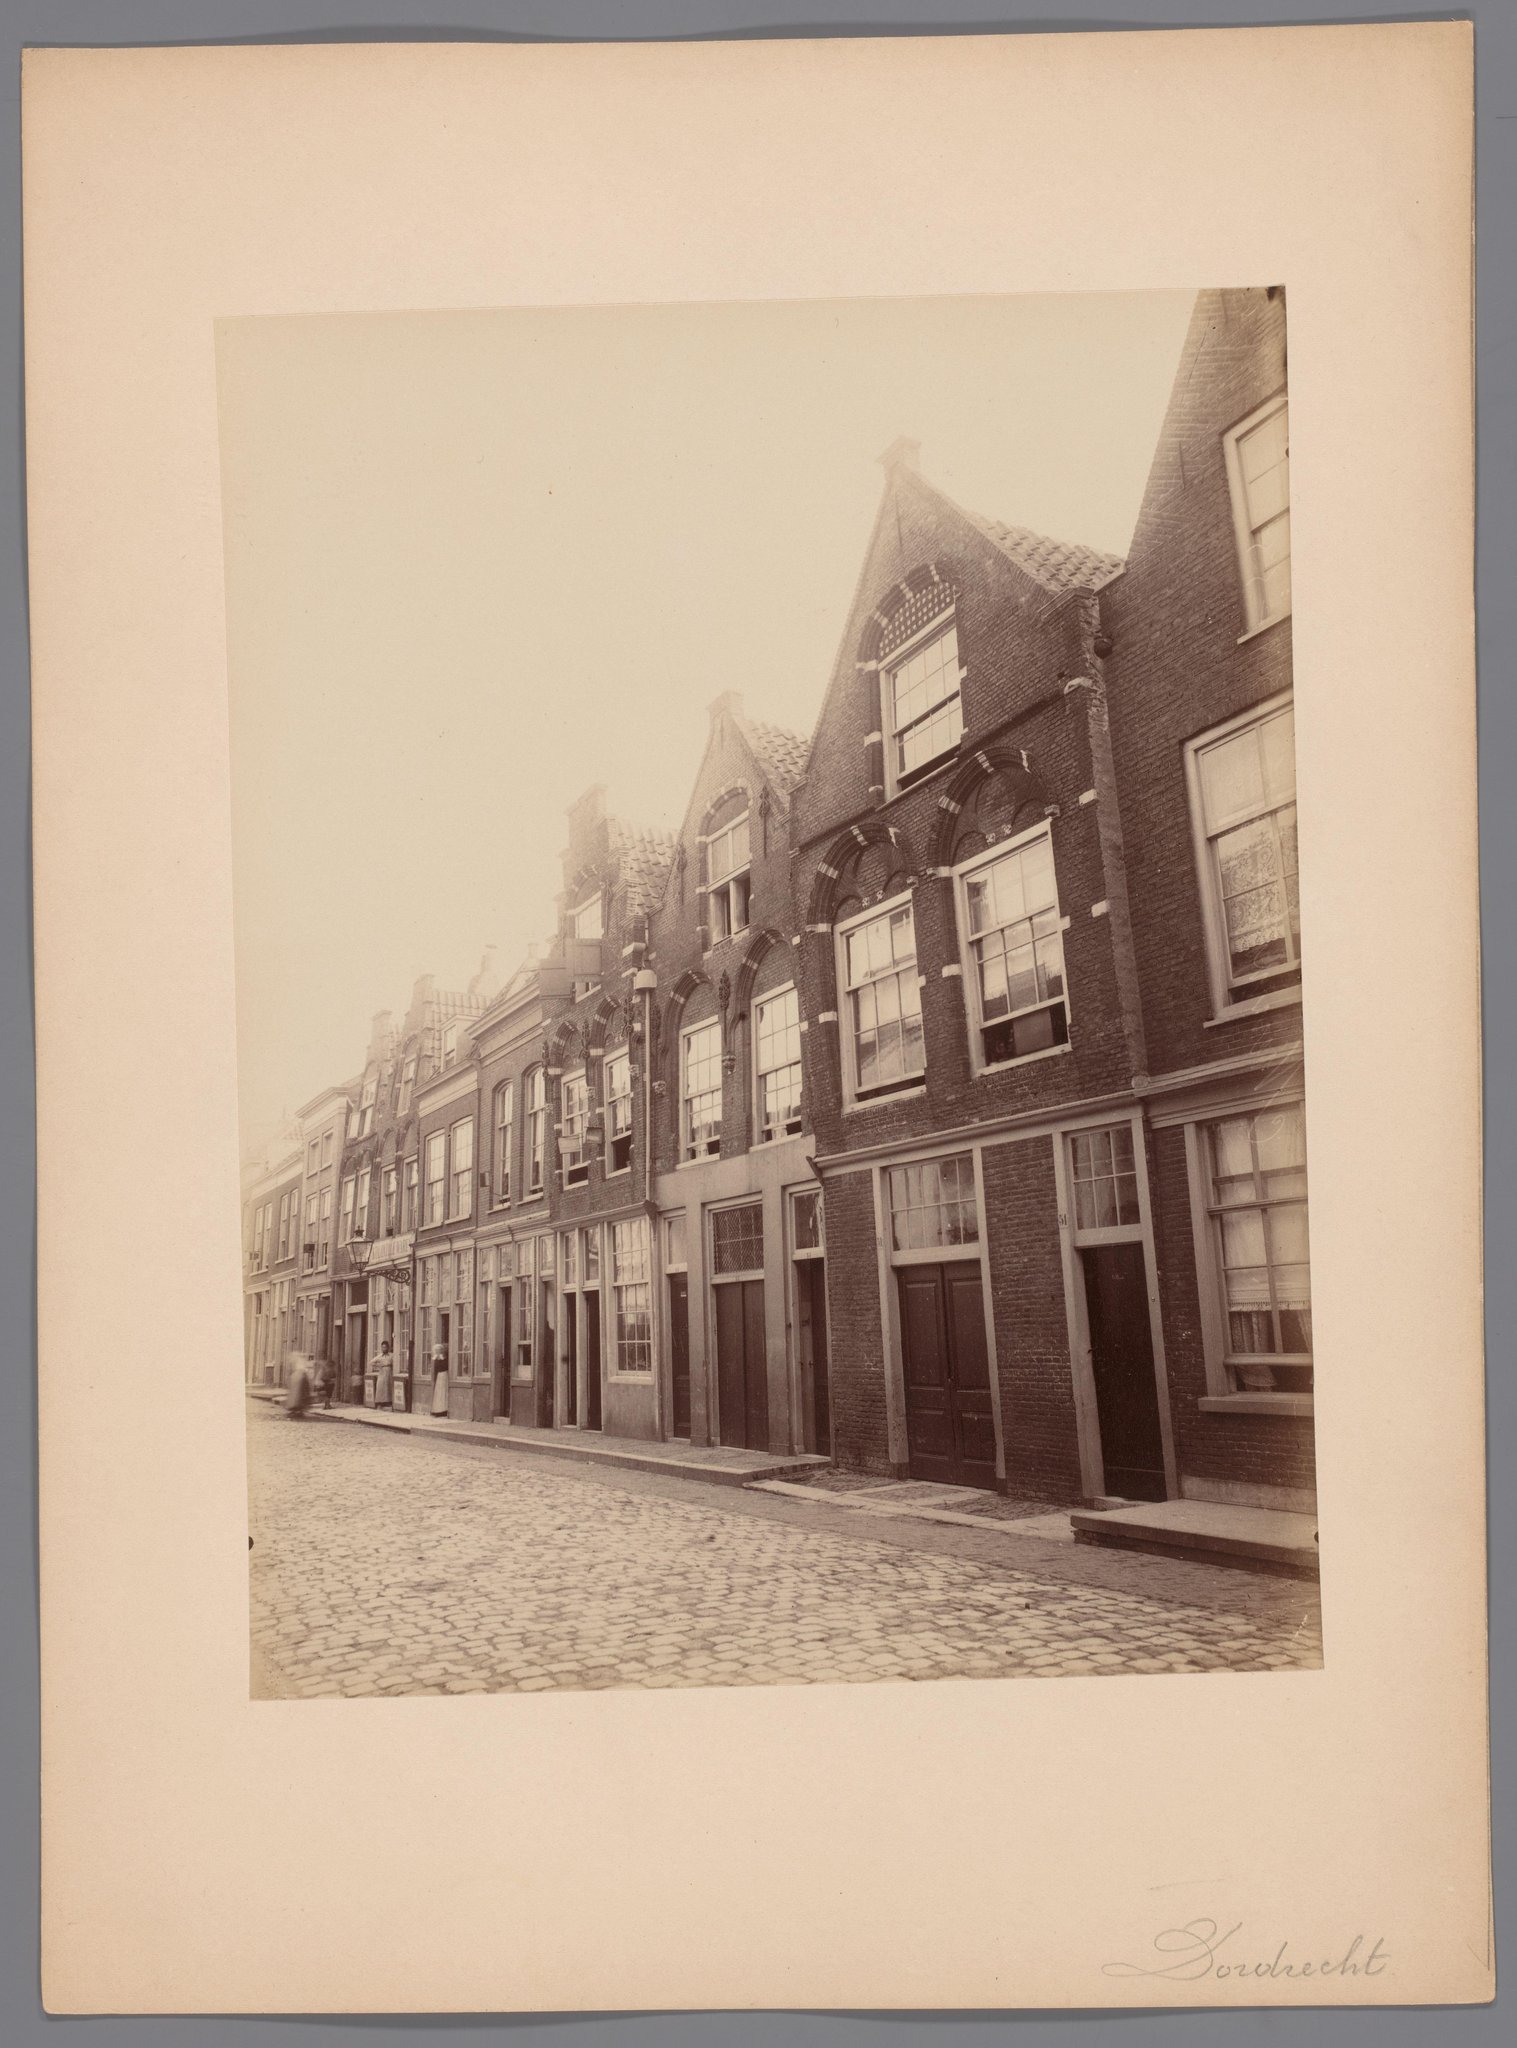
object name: photograph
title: Gezicht op de Nieuwstraat te Dordrecht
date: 1880-1910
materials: cardboard, photographic support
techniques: albumen print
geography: nieuwstraat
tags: façade (of house or building), street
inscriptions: annotation: ‘Dordrecht/ Huis 51. 53. 55. 61. 63’, annotation: ‘Dordrecht’